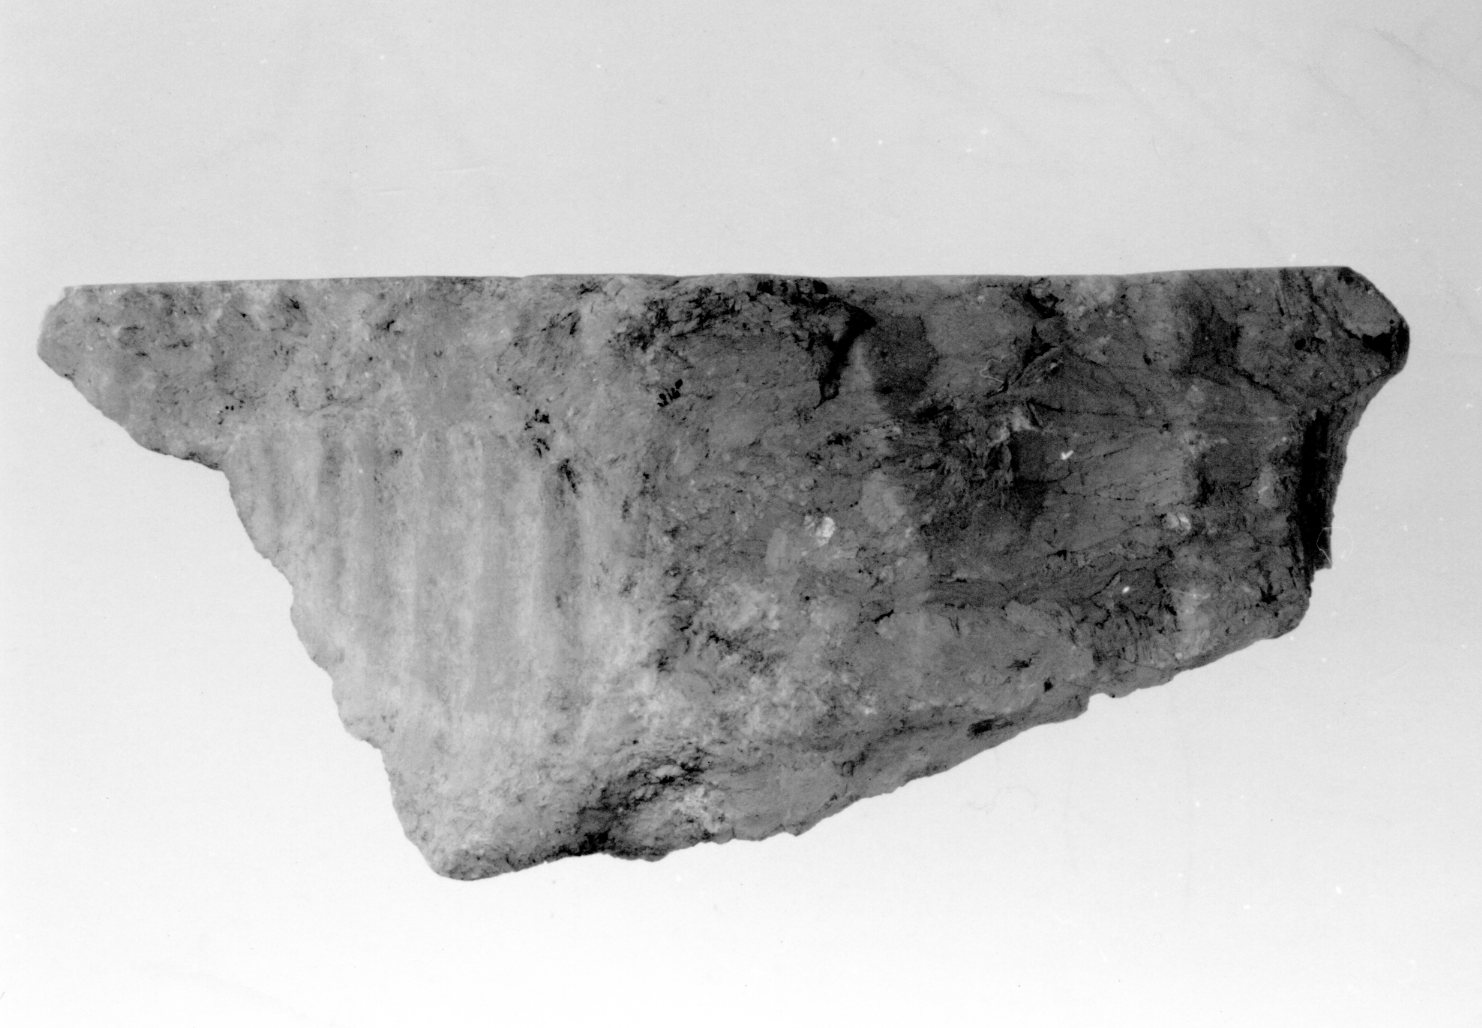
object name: canopic chest fragment, siptah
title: Canopic Chest Lid Fragment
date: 1194-1188 BCE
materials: stone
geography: egypt